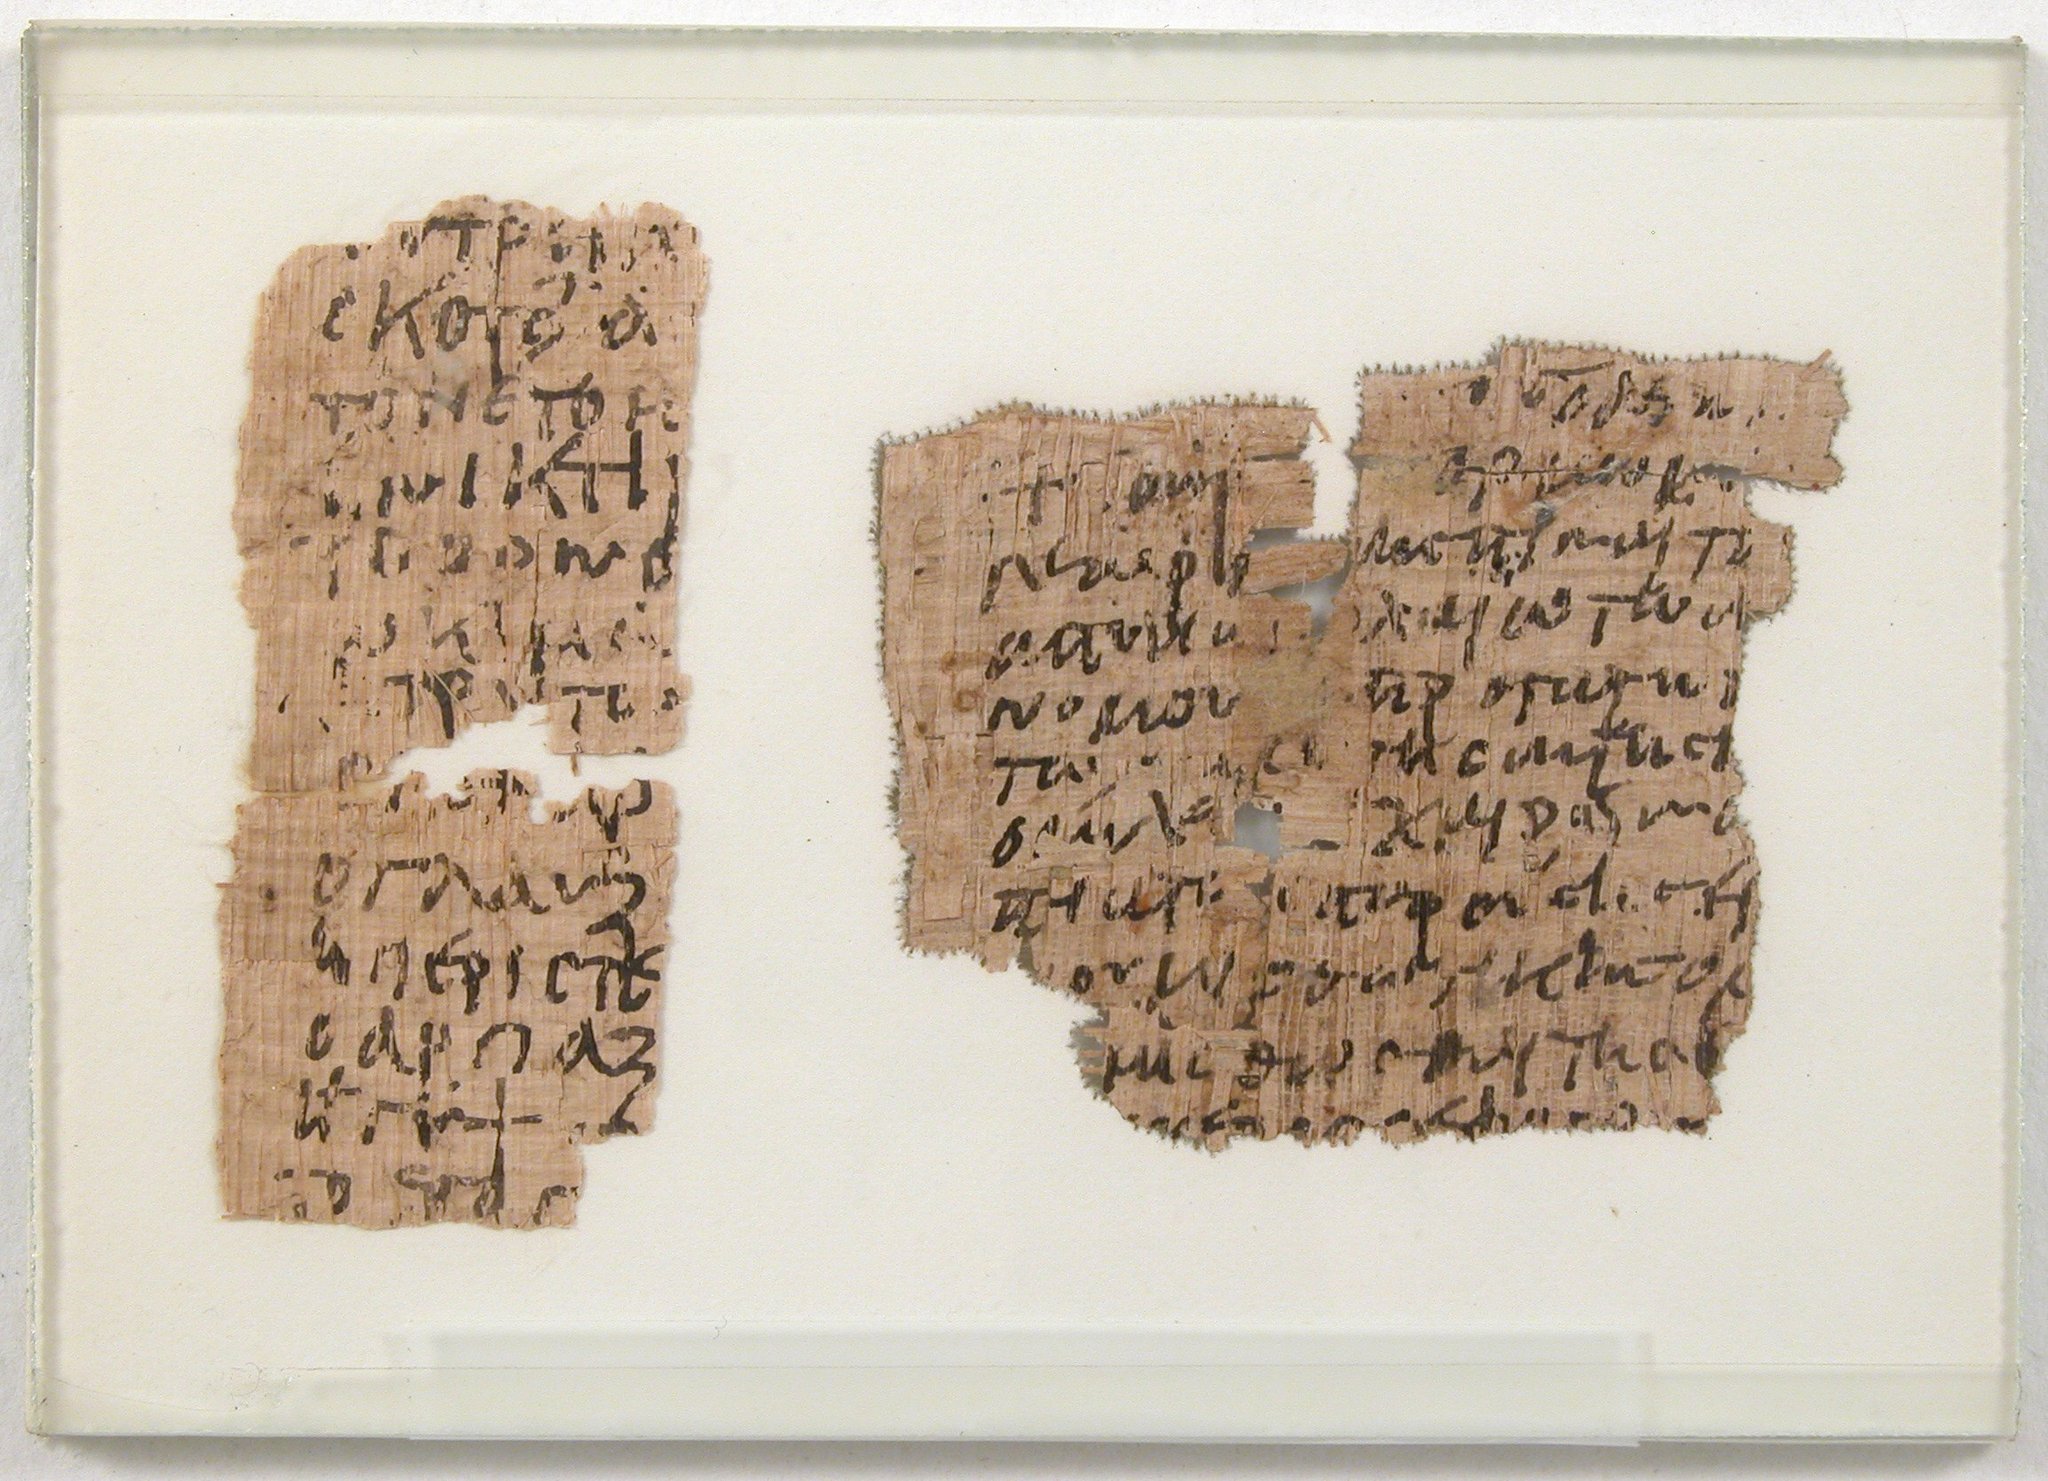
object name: fragment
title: Papyri Fragments of a List of Bird Names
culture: coptic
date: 580-640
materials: ink, papyrus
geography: egypt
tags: documents,greek